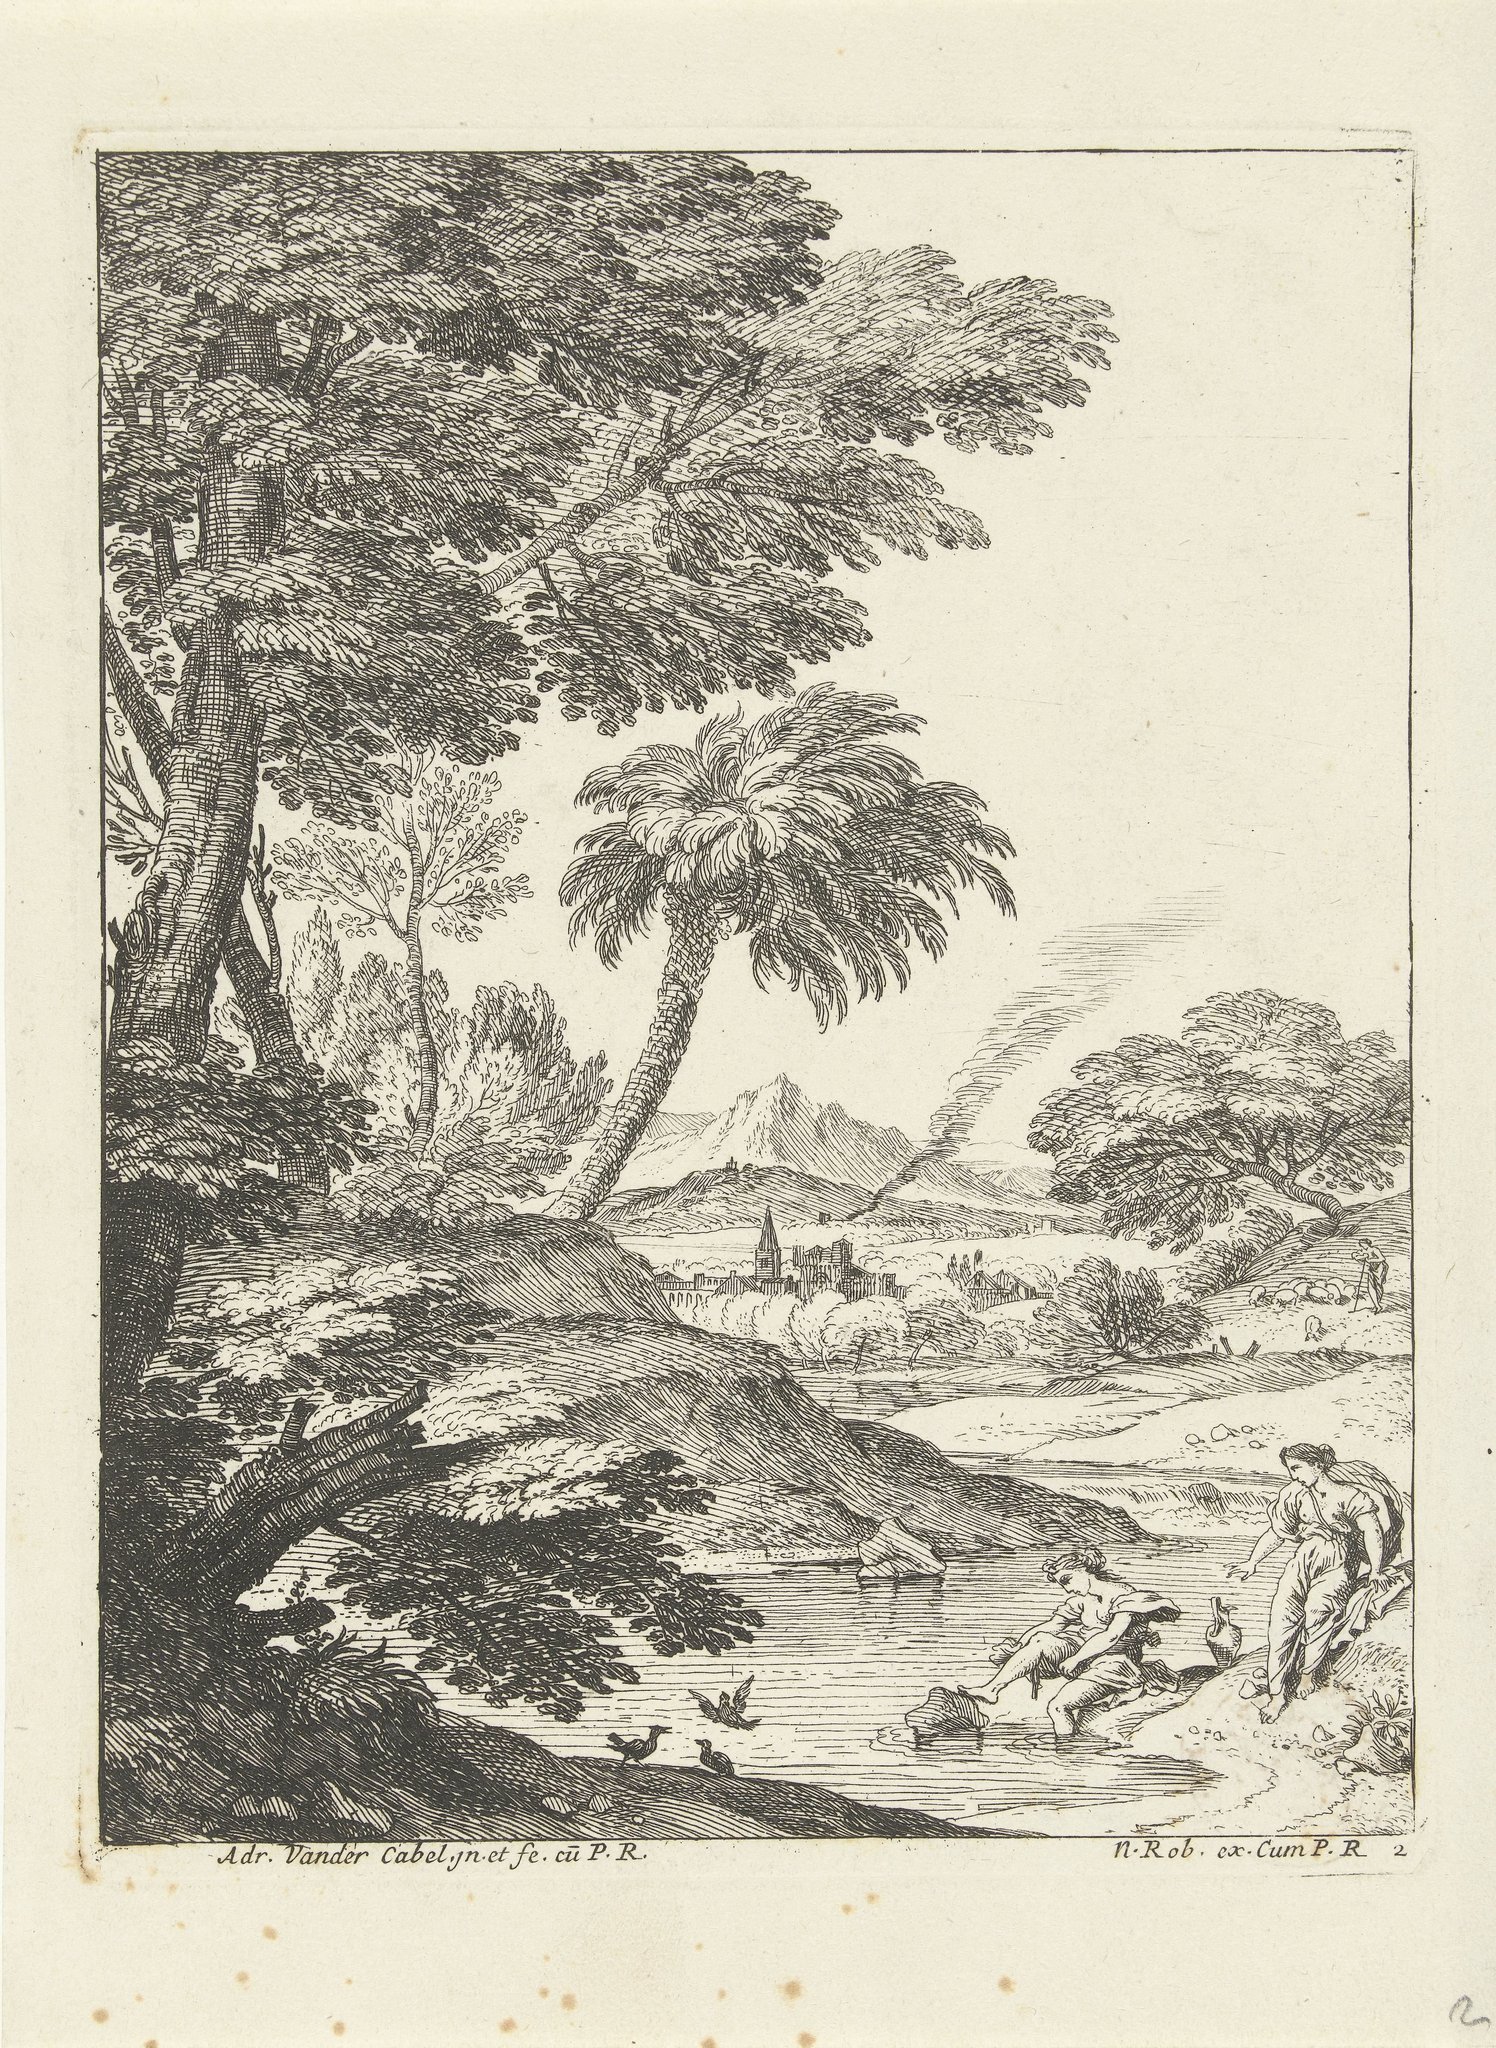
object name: print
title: Badende vrouw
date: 1648-1705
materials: paper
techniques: etching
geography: france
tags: landscapes, herding, herdsman, herdswoman, shepherd, shepherdess, cowherd, etc., washing and bathing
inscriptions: collector's mark: Lugt 240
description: Landschap met grote bomen; op de voorgrond twee vrouwen bij een rivier, op de achtergrond een schaapsherder en uitzicht op een stad.